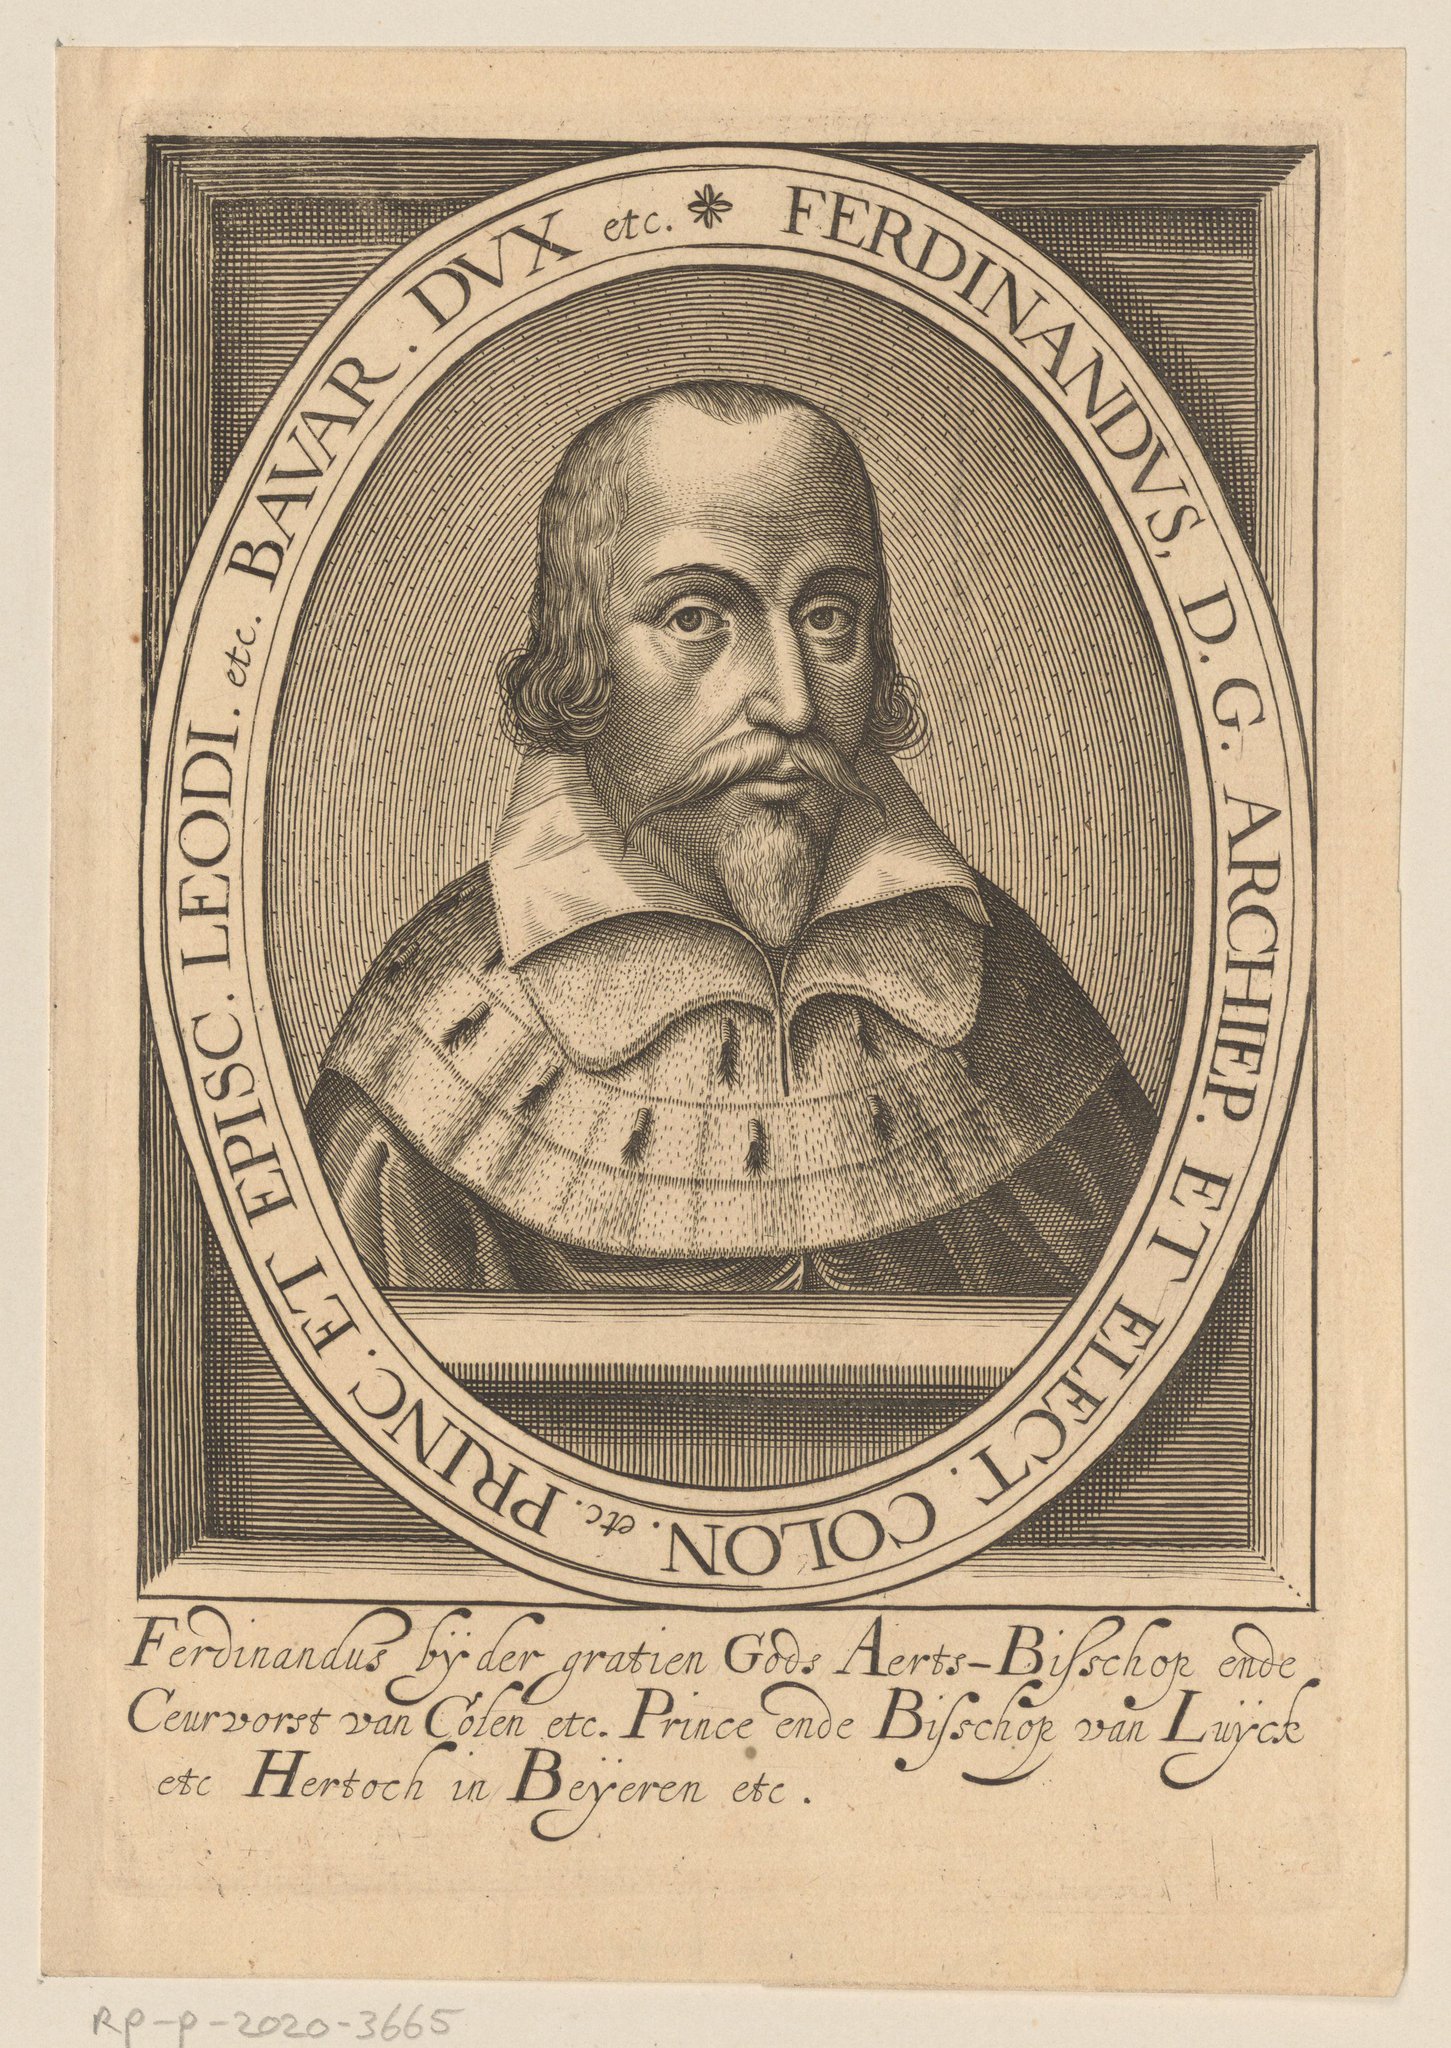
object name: print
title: Portret van Ferdinand van Beieren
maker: Anonymous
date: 1627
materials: paper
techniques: engraving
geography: northern netherlands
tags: ferdinand van beieren, historical persons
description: Prent met omlijsting gebruikt in: Meteren, Emanuel van. Der Niderländischer historien Ander Thail (...). Amsterdam: Johannes Janssonius, 1627. Prent mogelijk ook gebruikt in andere edities en vertalingen van Emanuel van Meterens 'Nederlantsche Historien'.